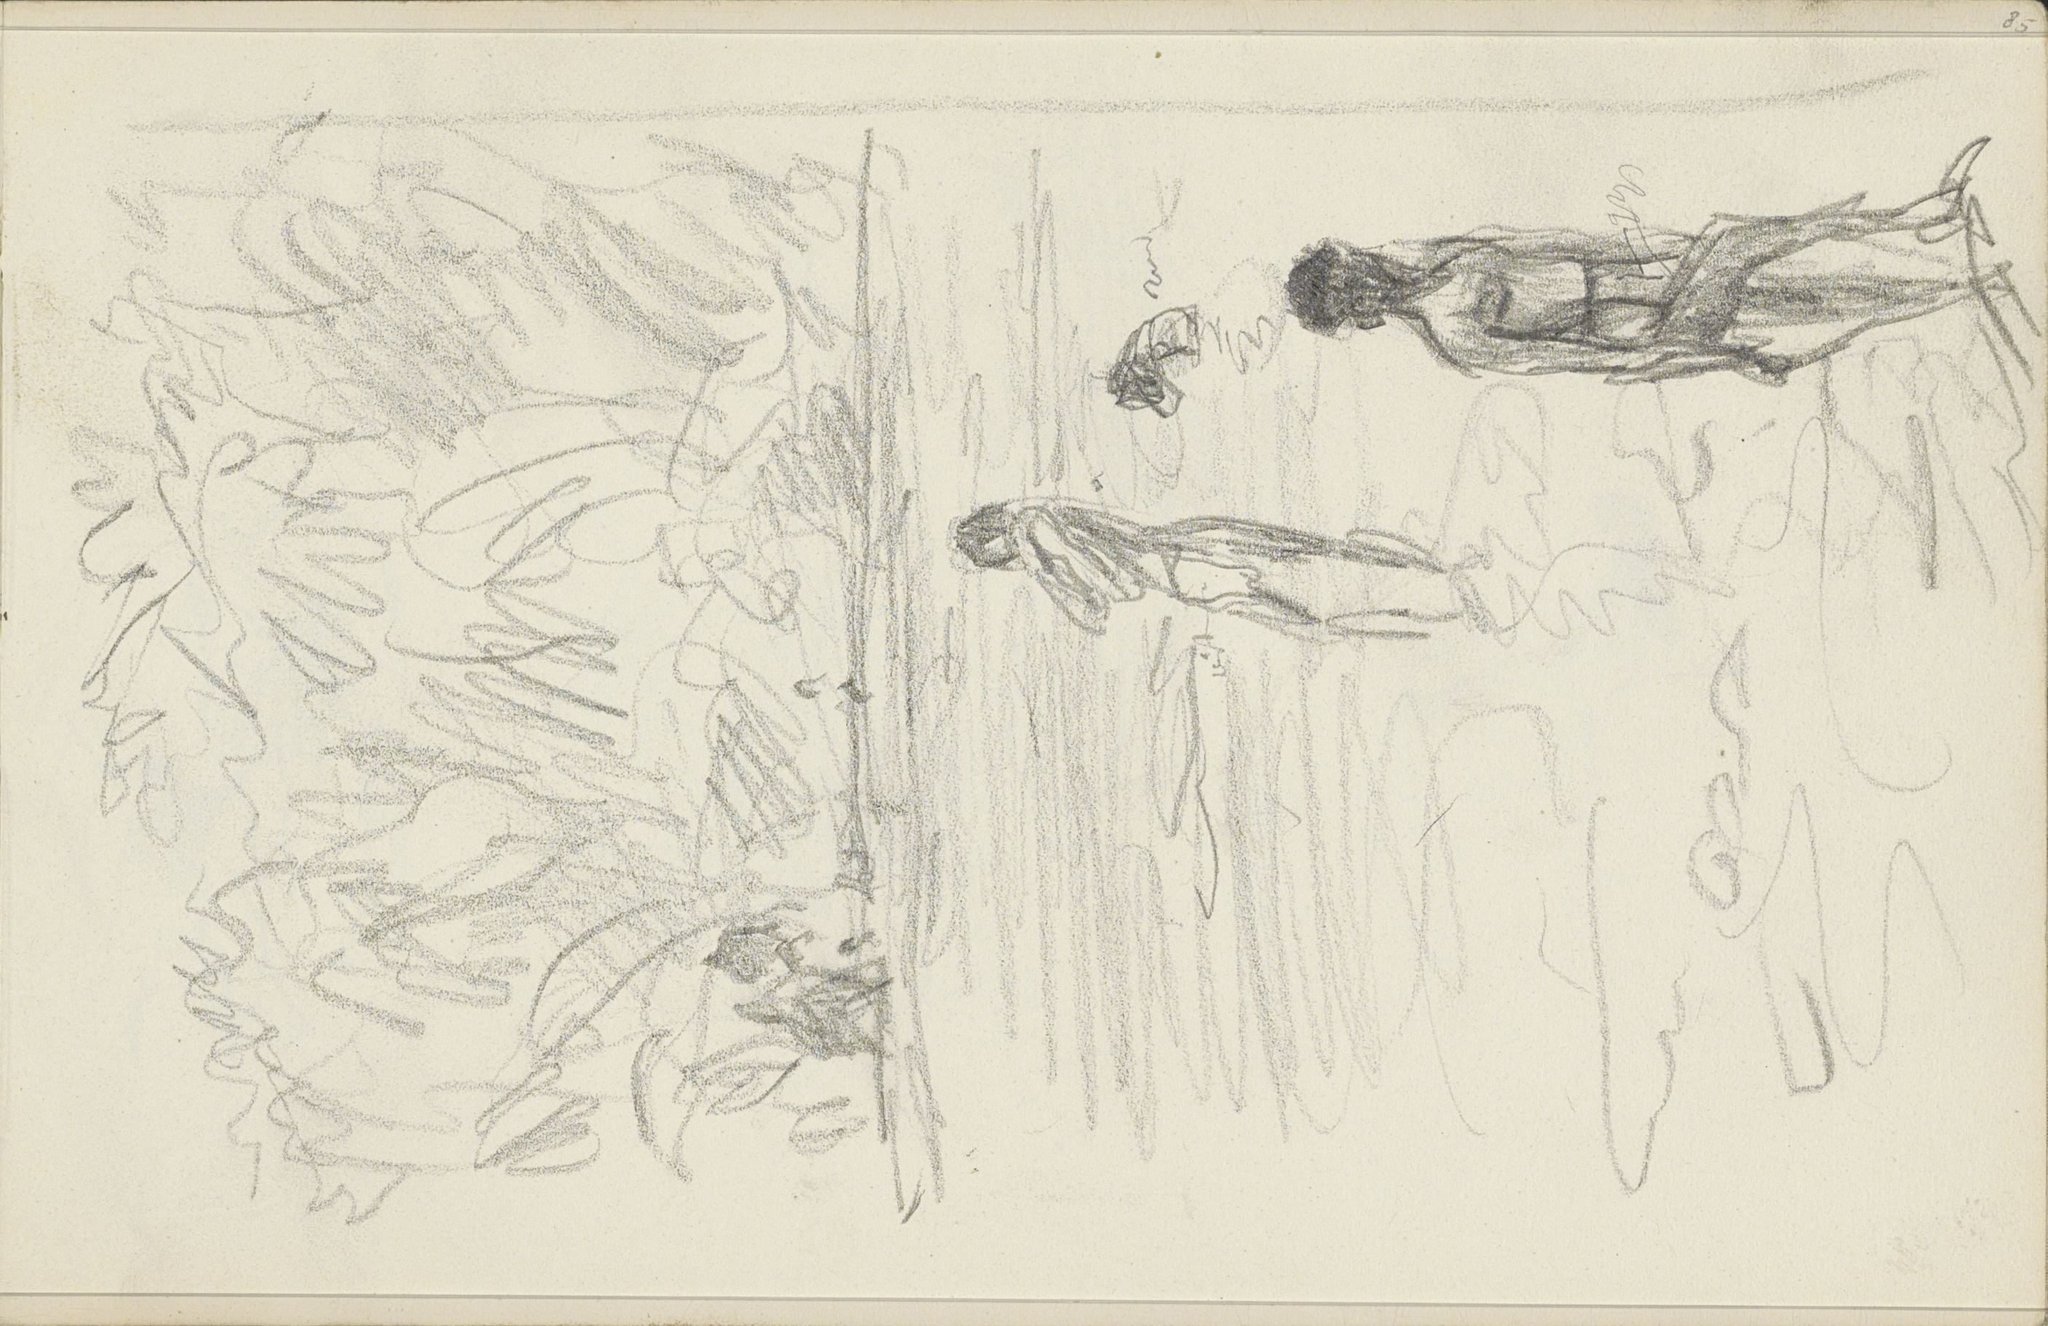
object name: sketchbook leaf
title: Badende Indiërs in een rivier in het oerwoud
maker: marius bauer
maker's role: draughtsman, print maker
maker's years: 1867-1932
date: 1924-1925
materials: paper, pencil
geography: india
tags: river, bathing (movement in water), jungle, asiatic races and peoples: indians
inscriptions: kleurnotitie, handgeschreven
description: Pagina 85 uit een schetsboek met 48 bladen.